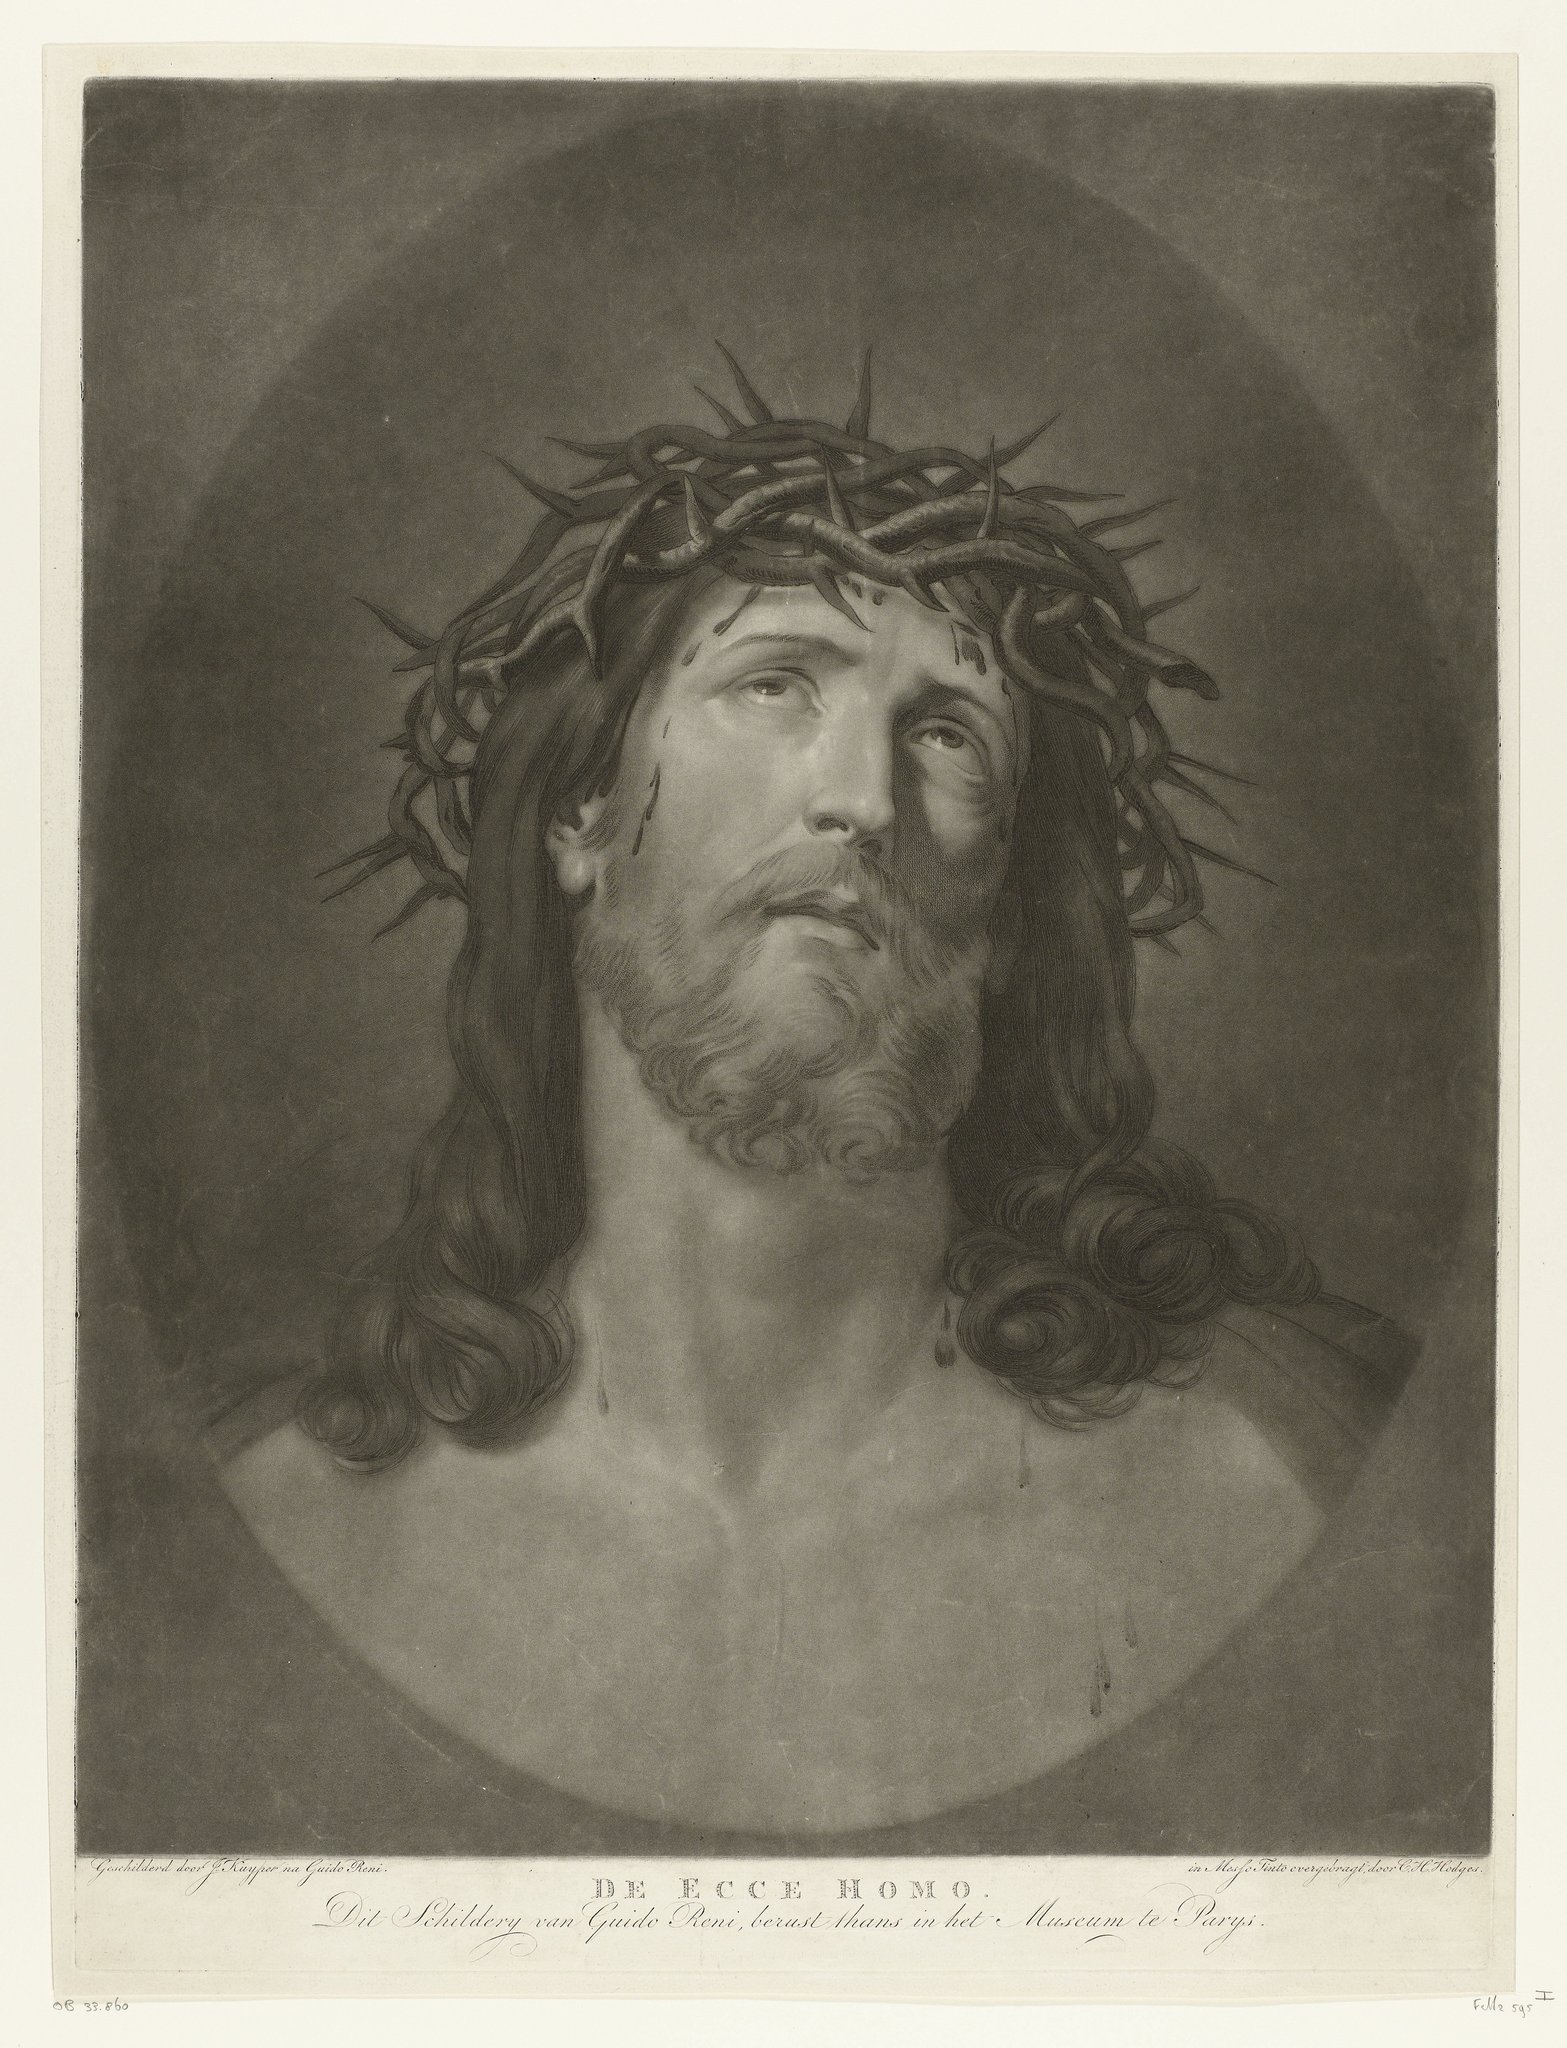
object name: print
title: Ecce Homo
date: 1806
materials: paper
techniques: etching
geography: amsterdam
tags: christ alone (also called 'ecce homo')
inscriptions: collector's mark: Lugt 2228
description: Christus met de doornenkroon en een mantel. (Joh. 19.5).